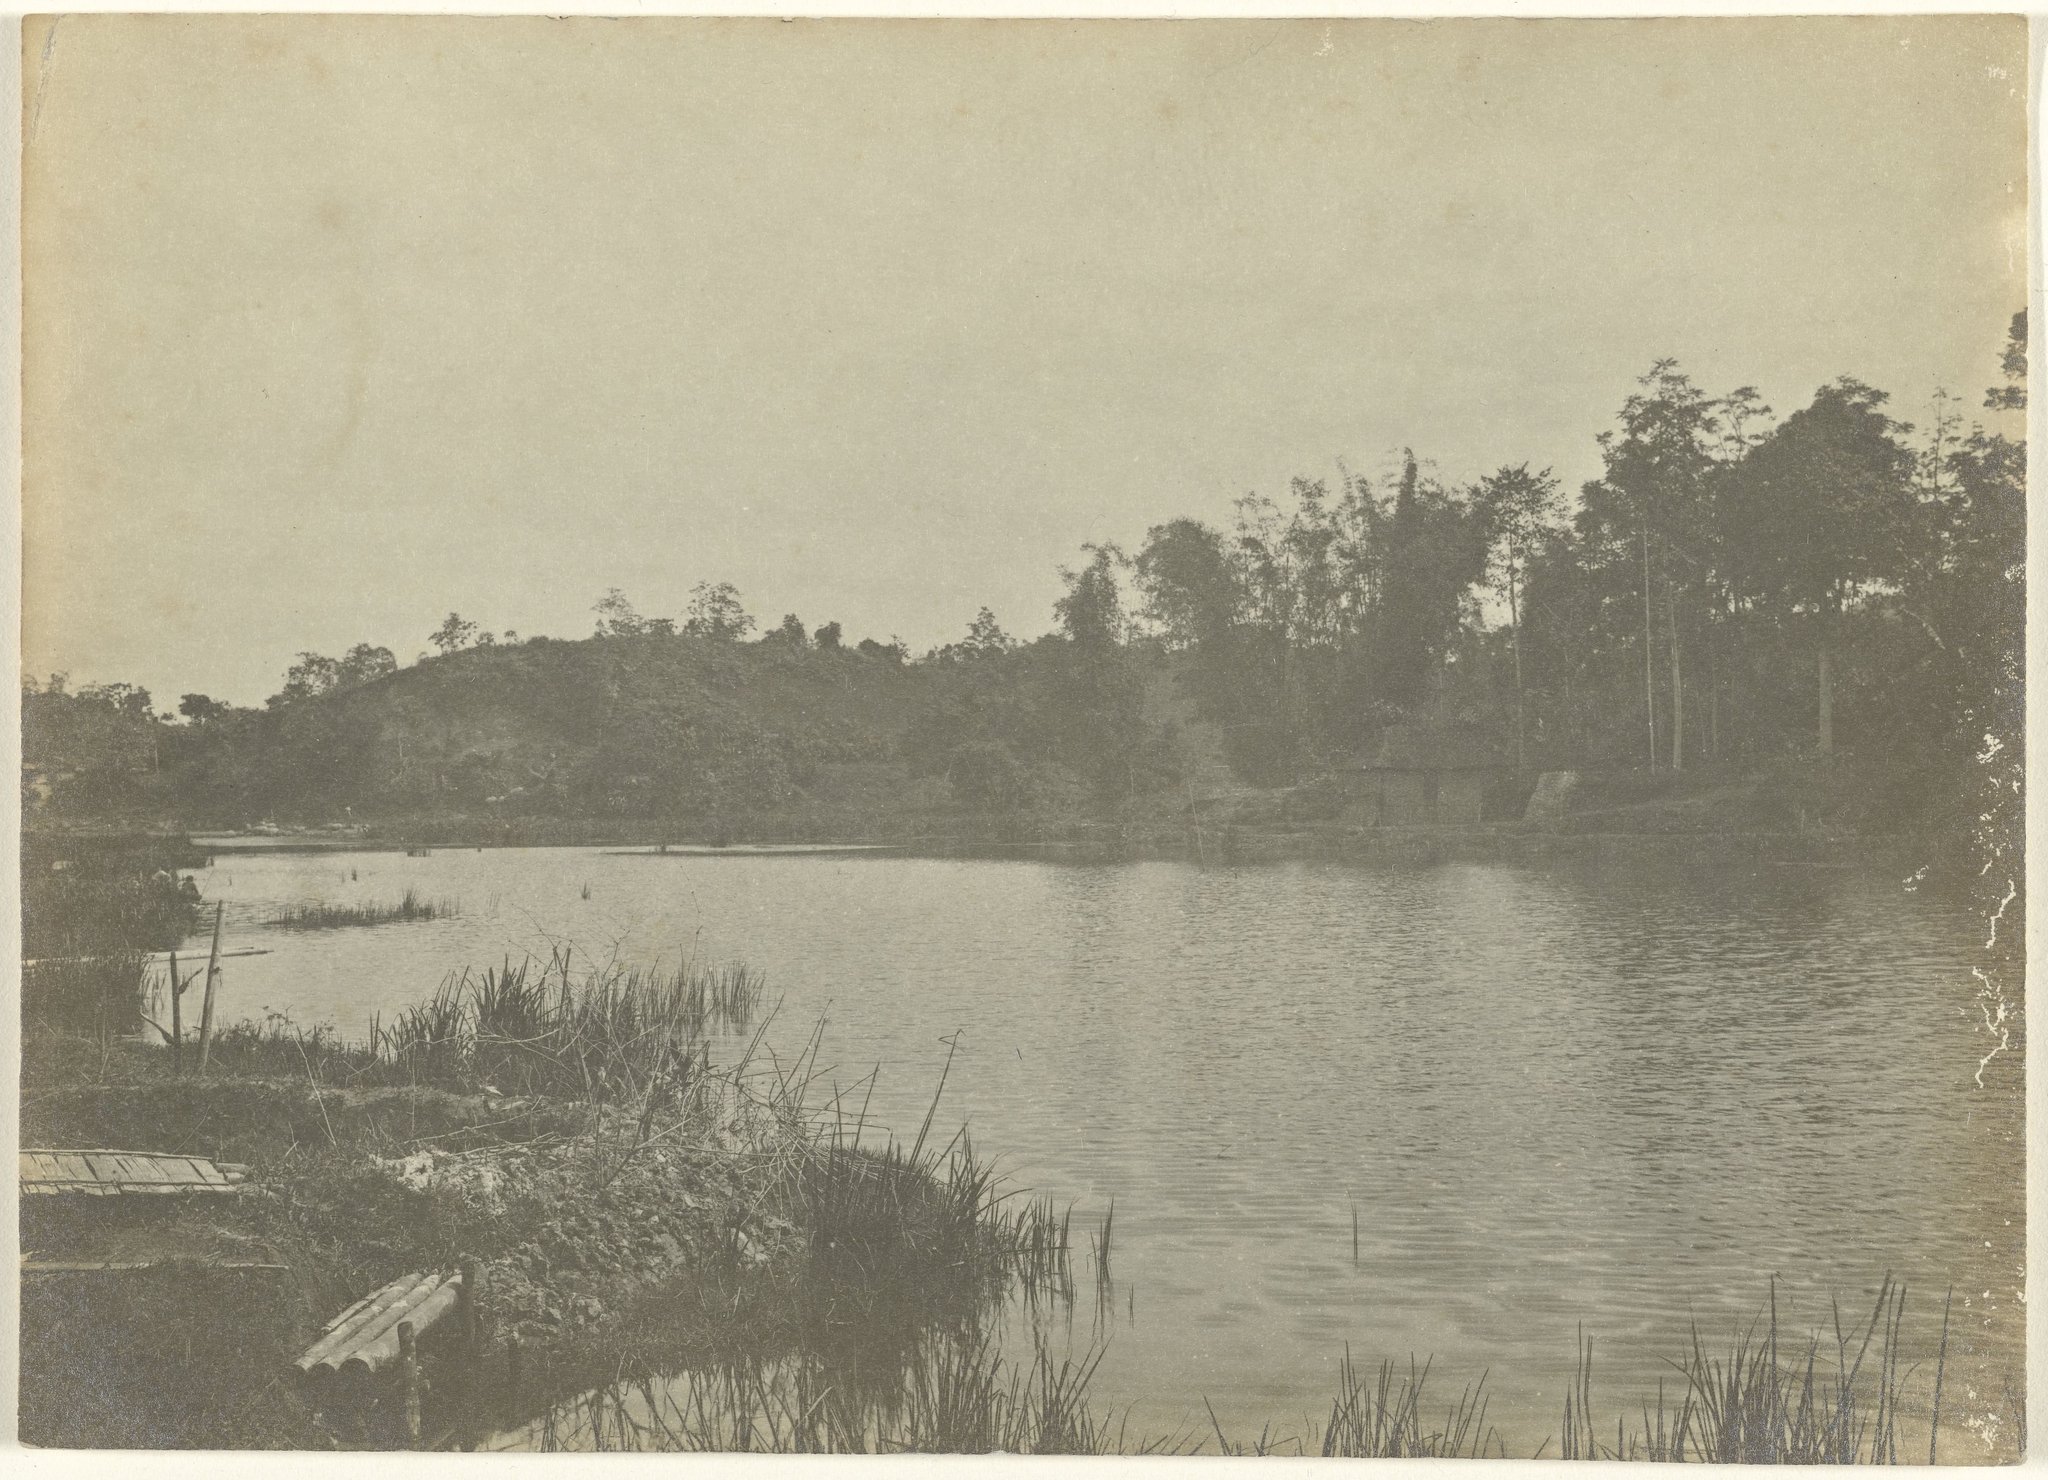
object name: photograph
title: Meertje bij het raceterrein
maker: Anonymous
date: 1900-1920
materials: paper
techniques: matte daylight collodion silver print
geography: indonesia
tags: lake, indonesia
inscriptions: inscription: ‘meertje bij het race Terrrein’